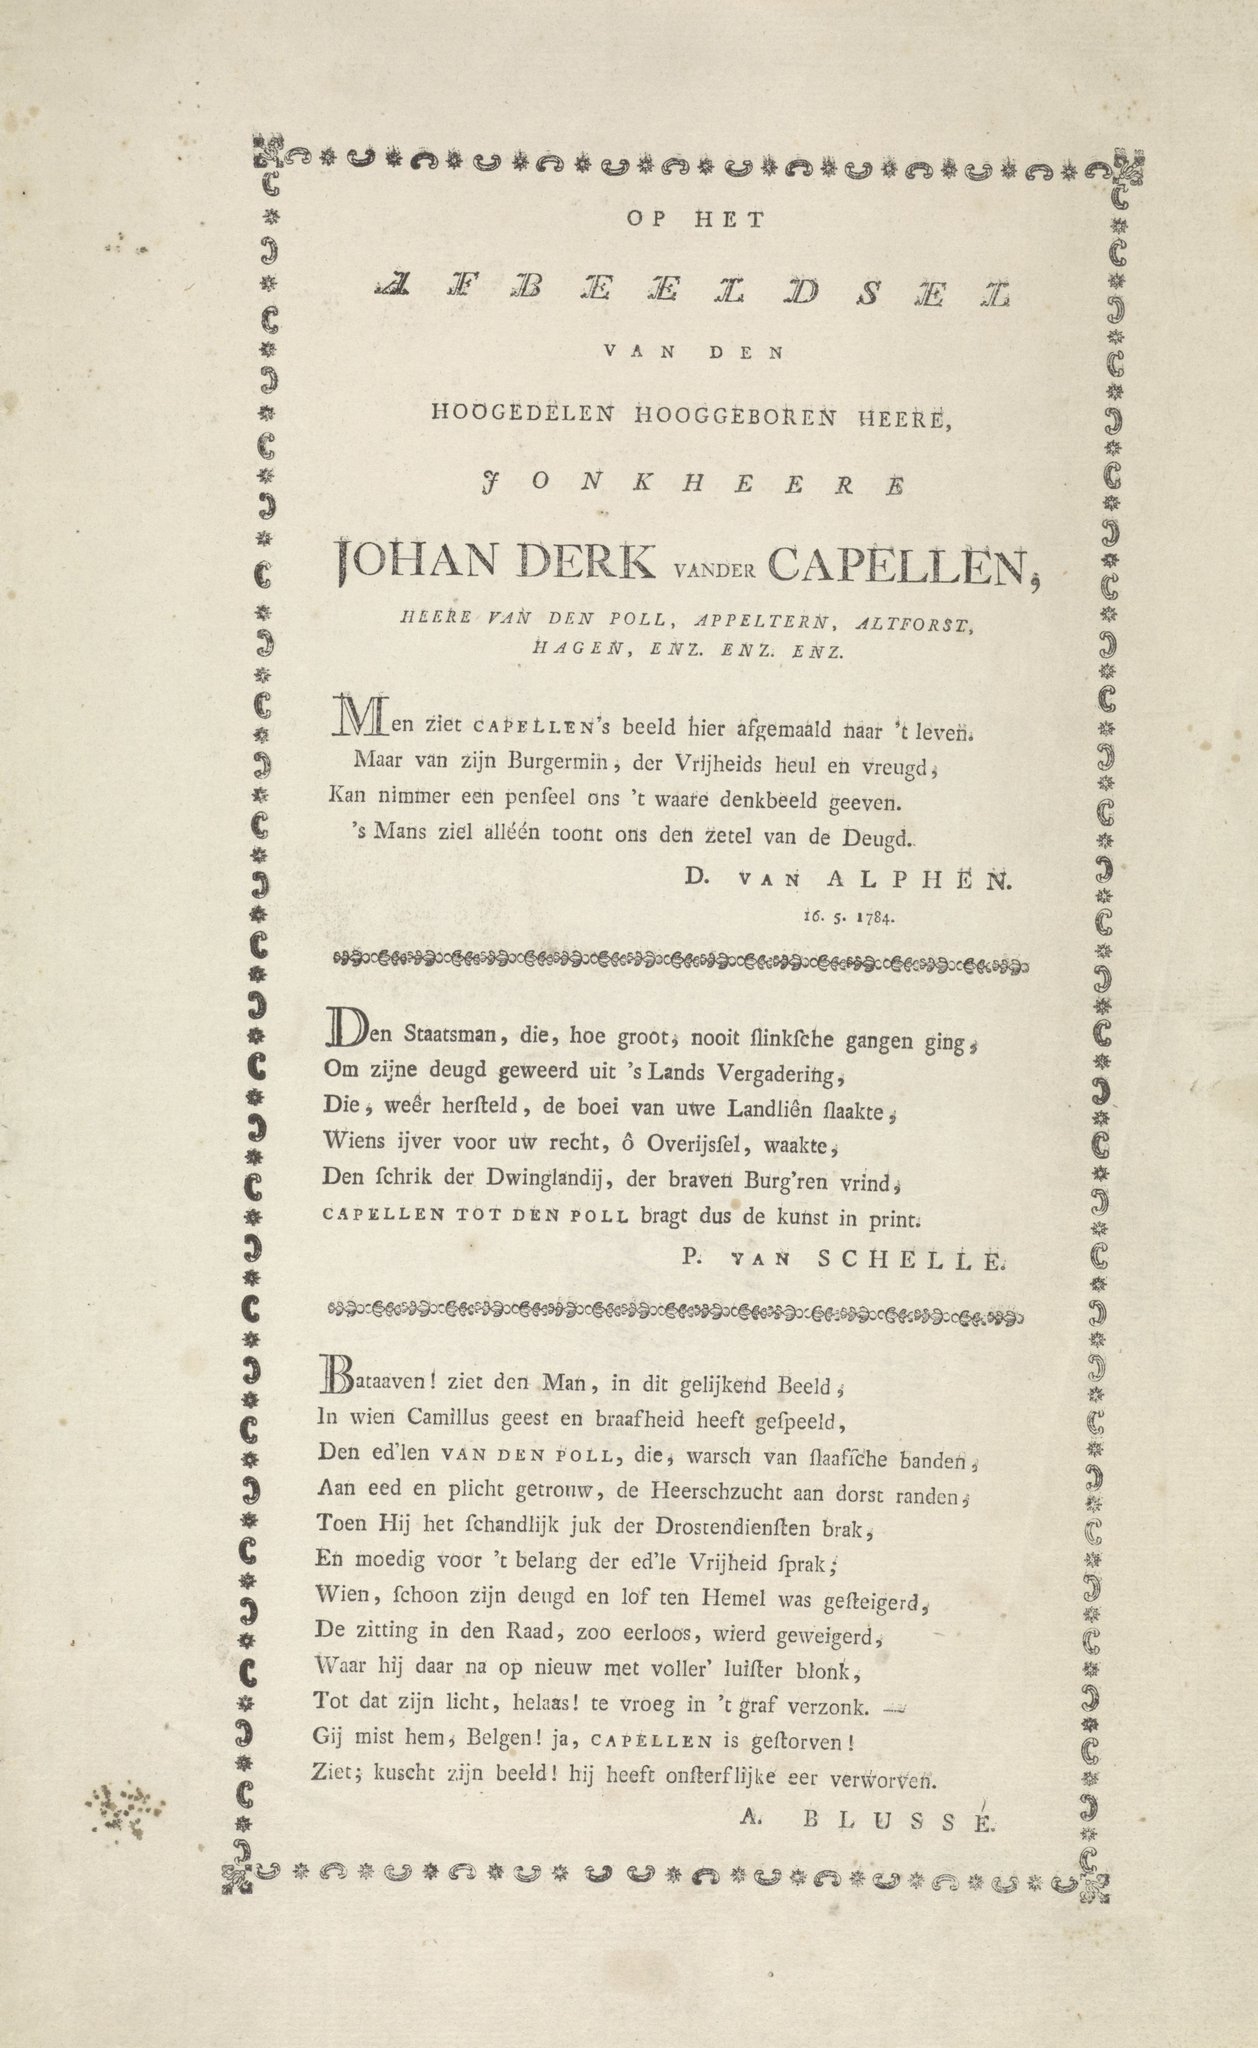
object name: text sheet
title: Vier lofdichten op de politicus Joan Derk van der Capellen tot den Pol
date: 1787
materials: paper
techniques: letterpress printing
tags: politician, joan derk van der capellen tot den pol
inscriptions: collector's mark: Lugt 2228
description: Lofdichten behorend bij het portret van de politicus Joan Derk van der Capellen tot den Pol (RP-P-1903-A-23375B).